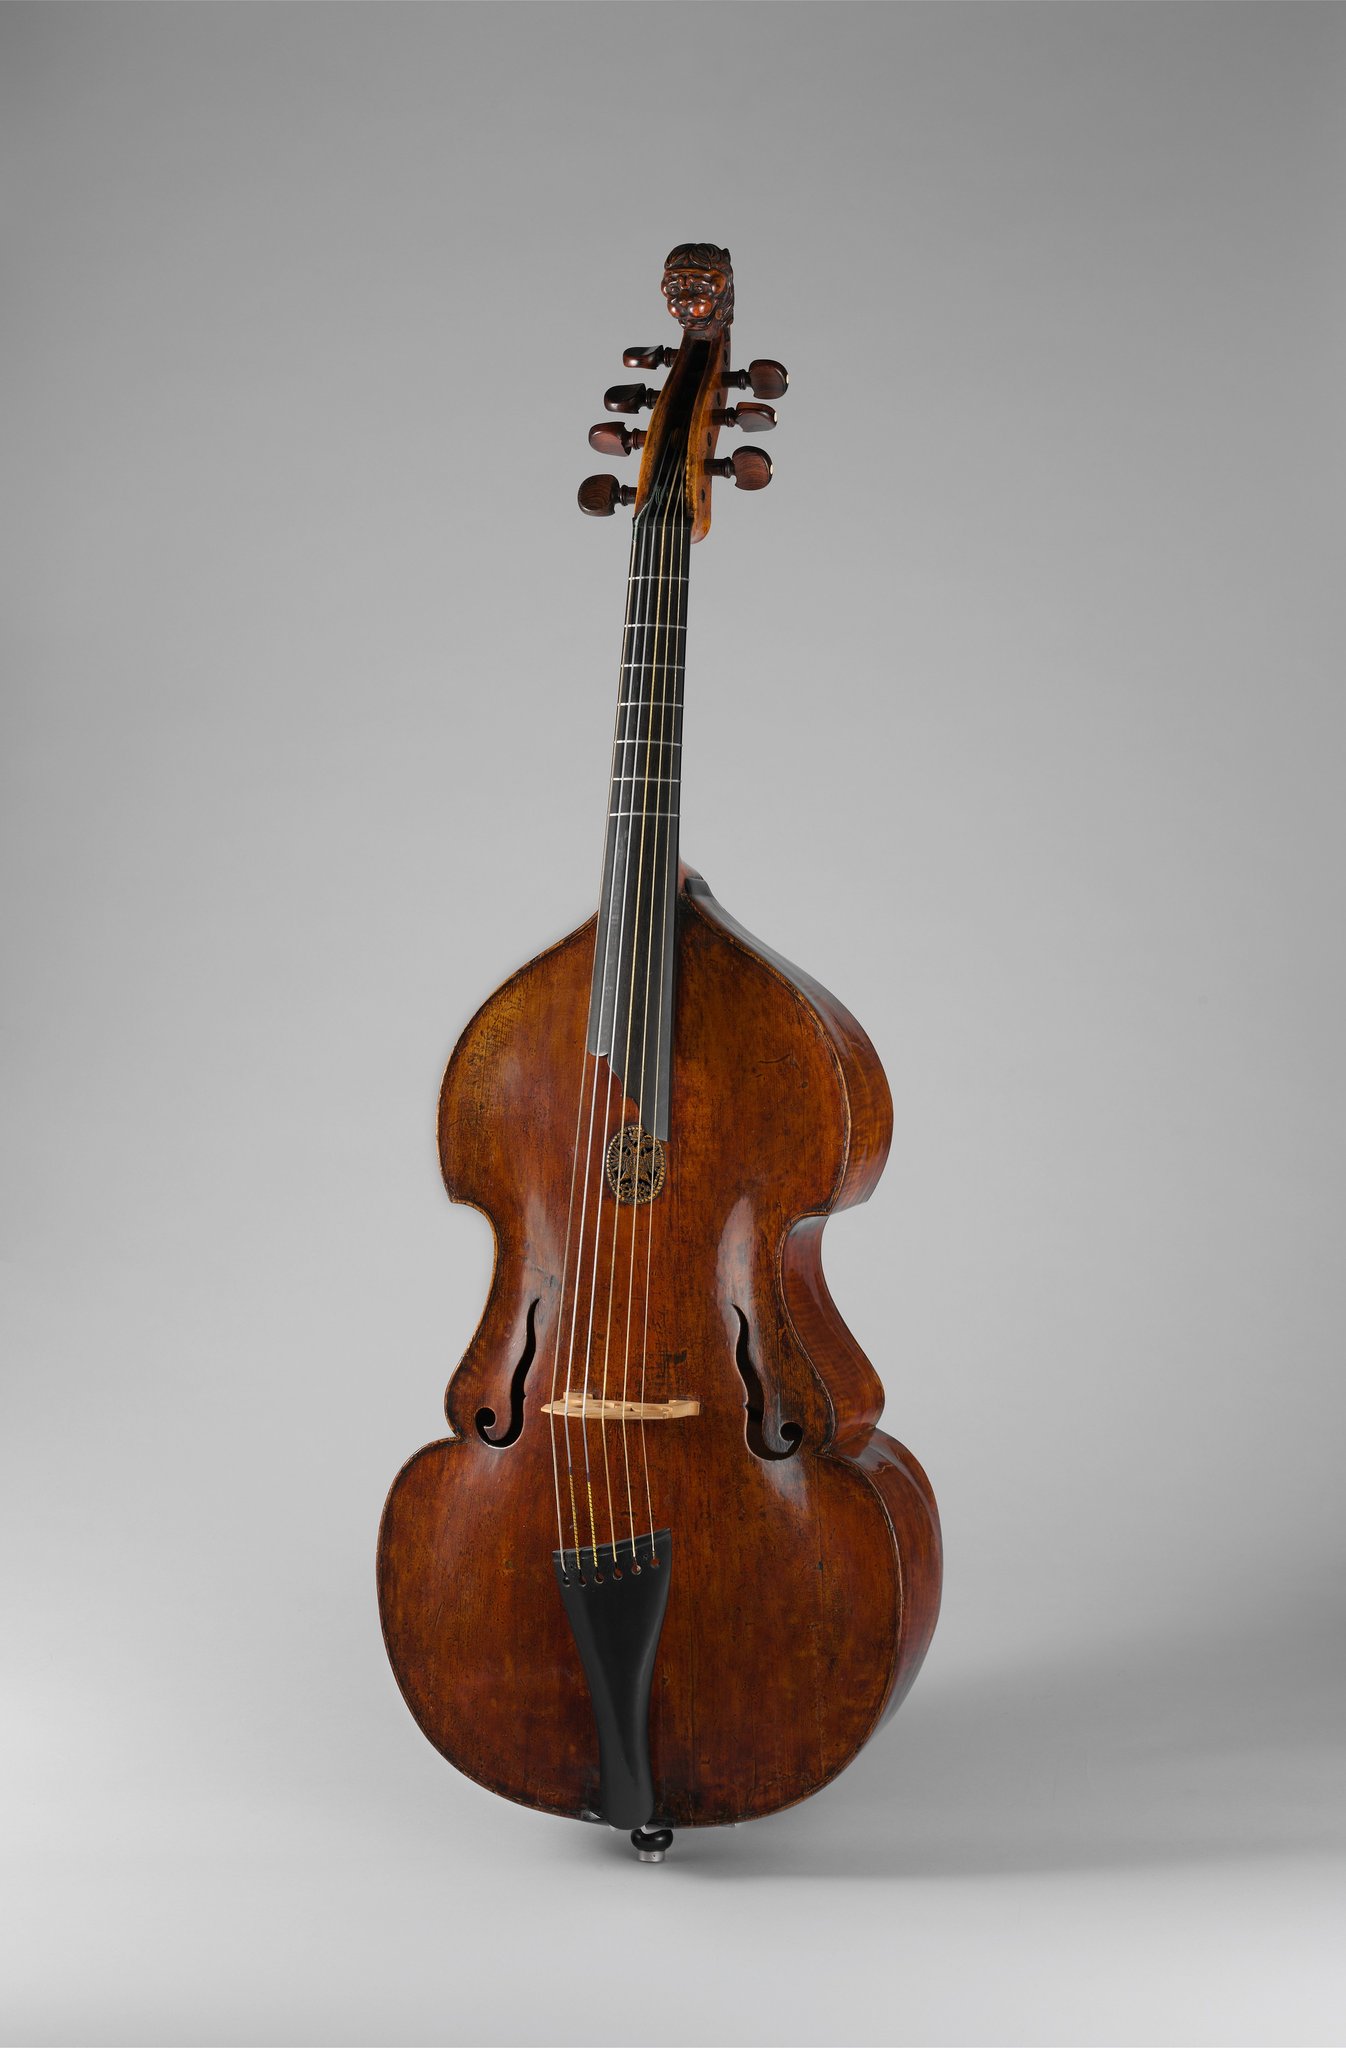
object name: bass viola da gamba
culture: austrian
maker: andreas jais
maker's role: maker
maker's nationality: german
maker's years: 1685-1753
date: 1701-1733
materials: wood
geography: austria